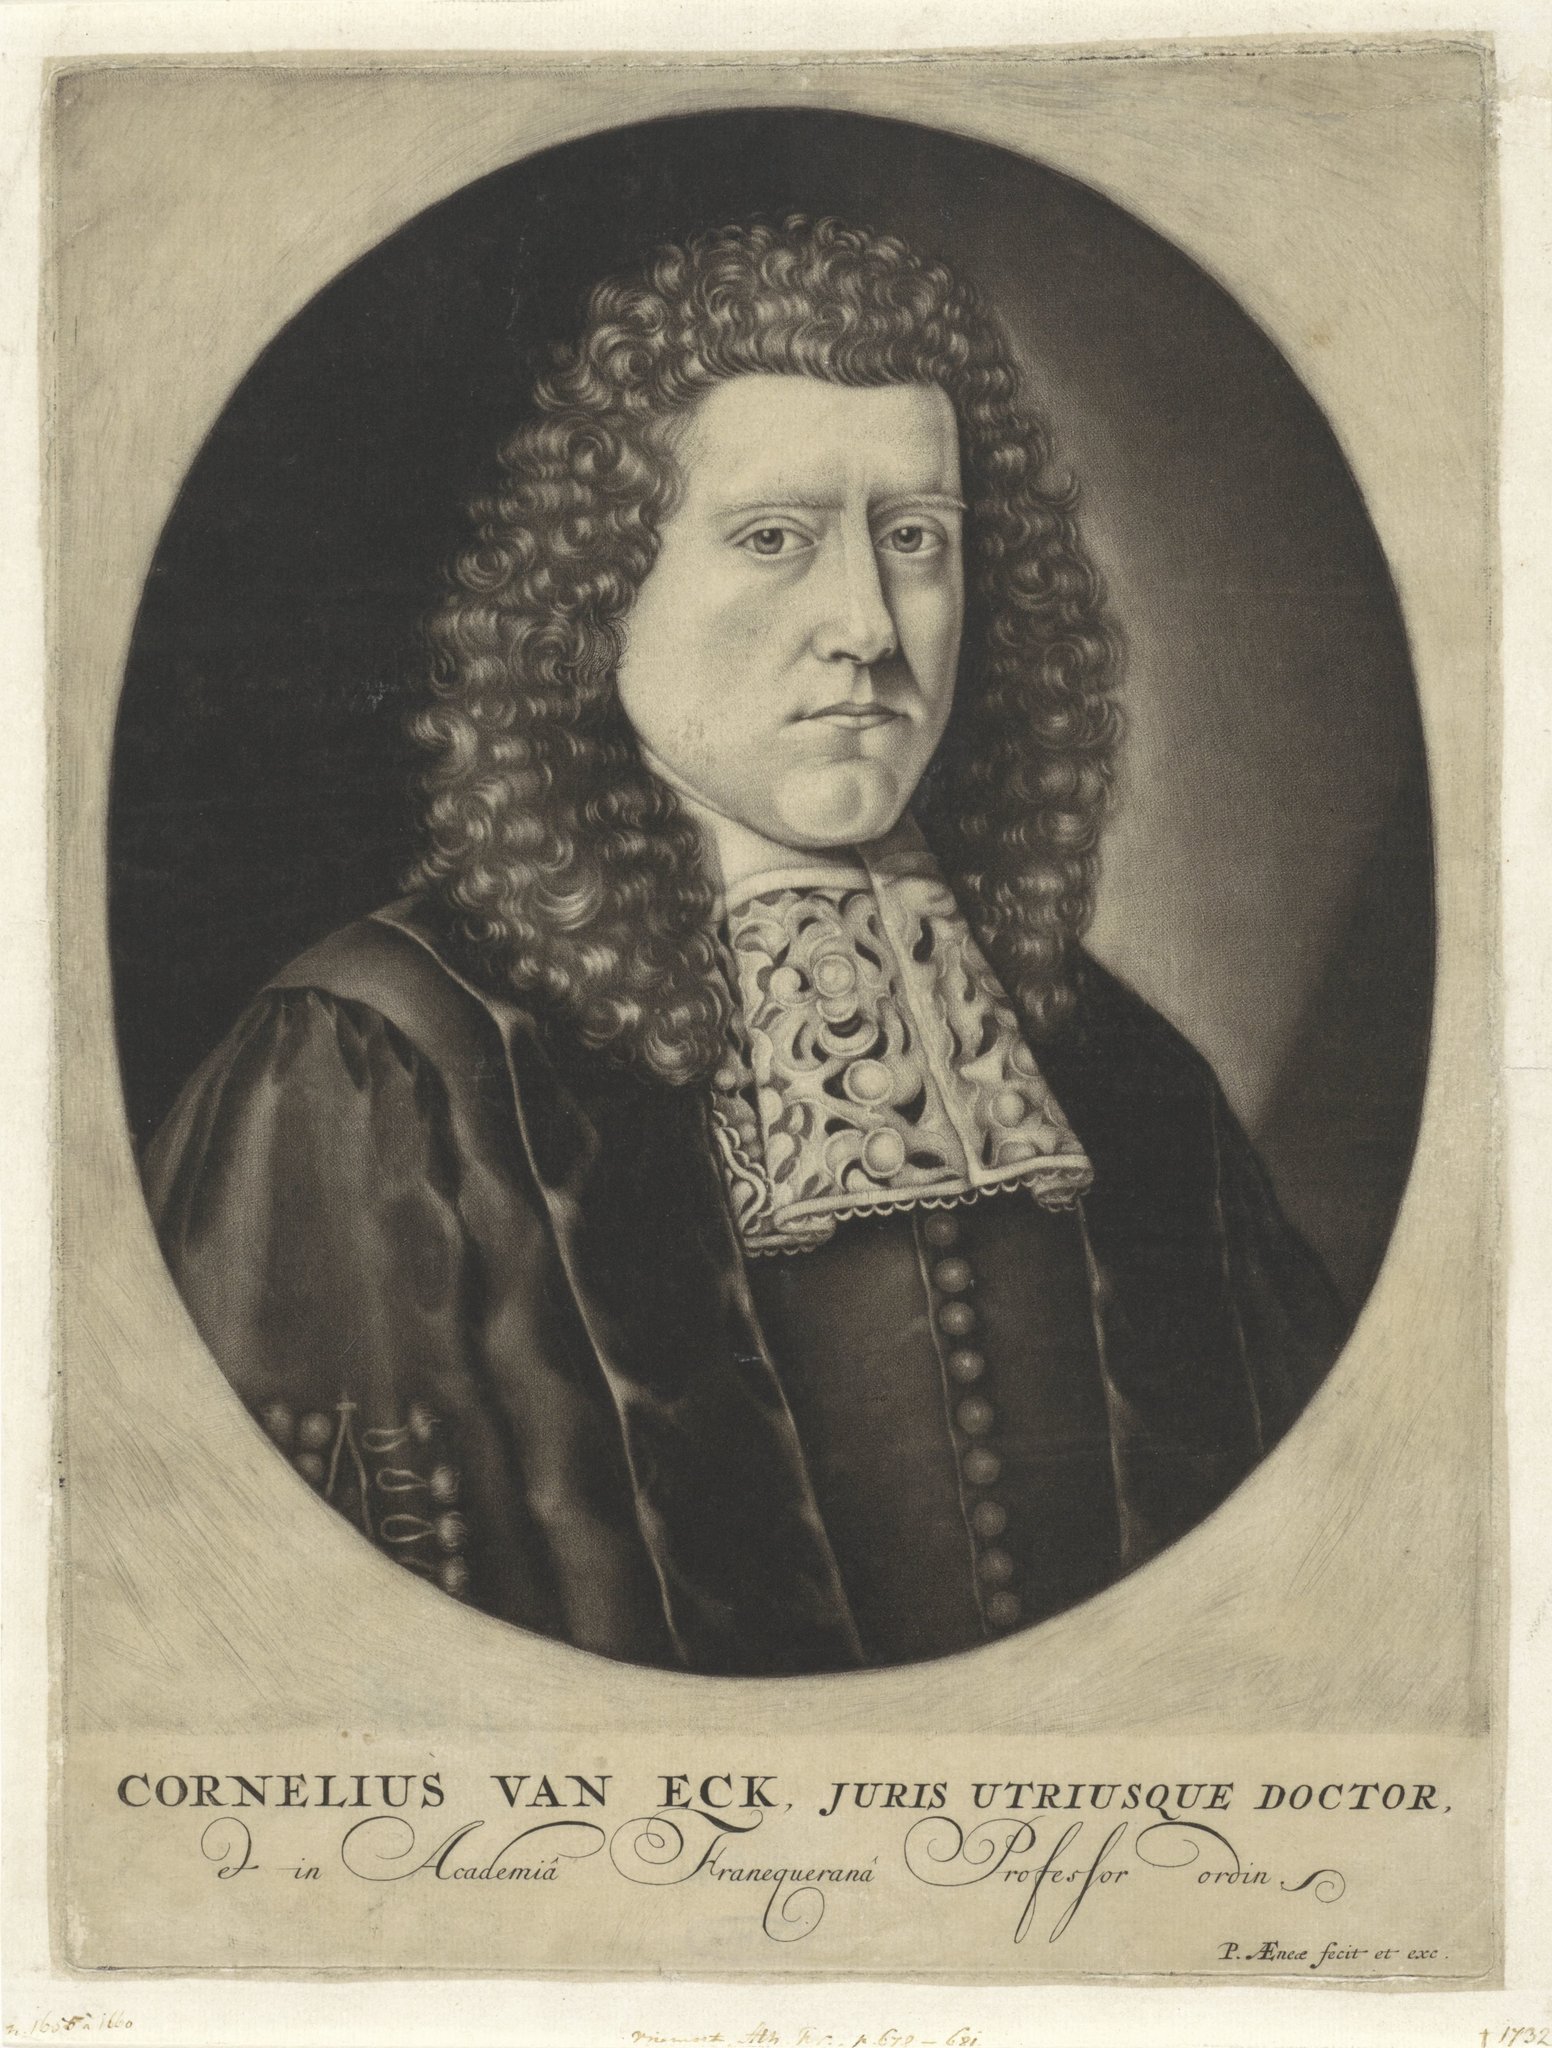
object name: print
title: Portret van Cornelius van Eck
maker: petrus aeneae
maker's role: painter, print maker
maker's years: 1650-1727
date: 1680-1693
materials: paper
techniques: engraving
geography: franeker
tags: cornelis van eck, wig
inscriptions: collector's mark: Lugt 2228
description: Portret van Cornelius van Eck, hoogleraar in het recht te Franeker en vanaf 1693 in Utrecht. Hij draagt een pruik. In de marge zijn naam en titels.